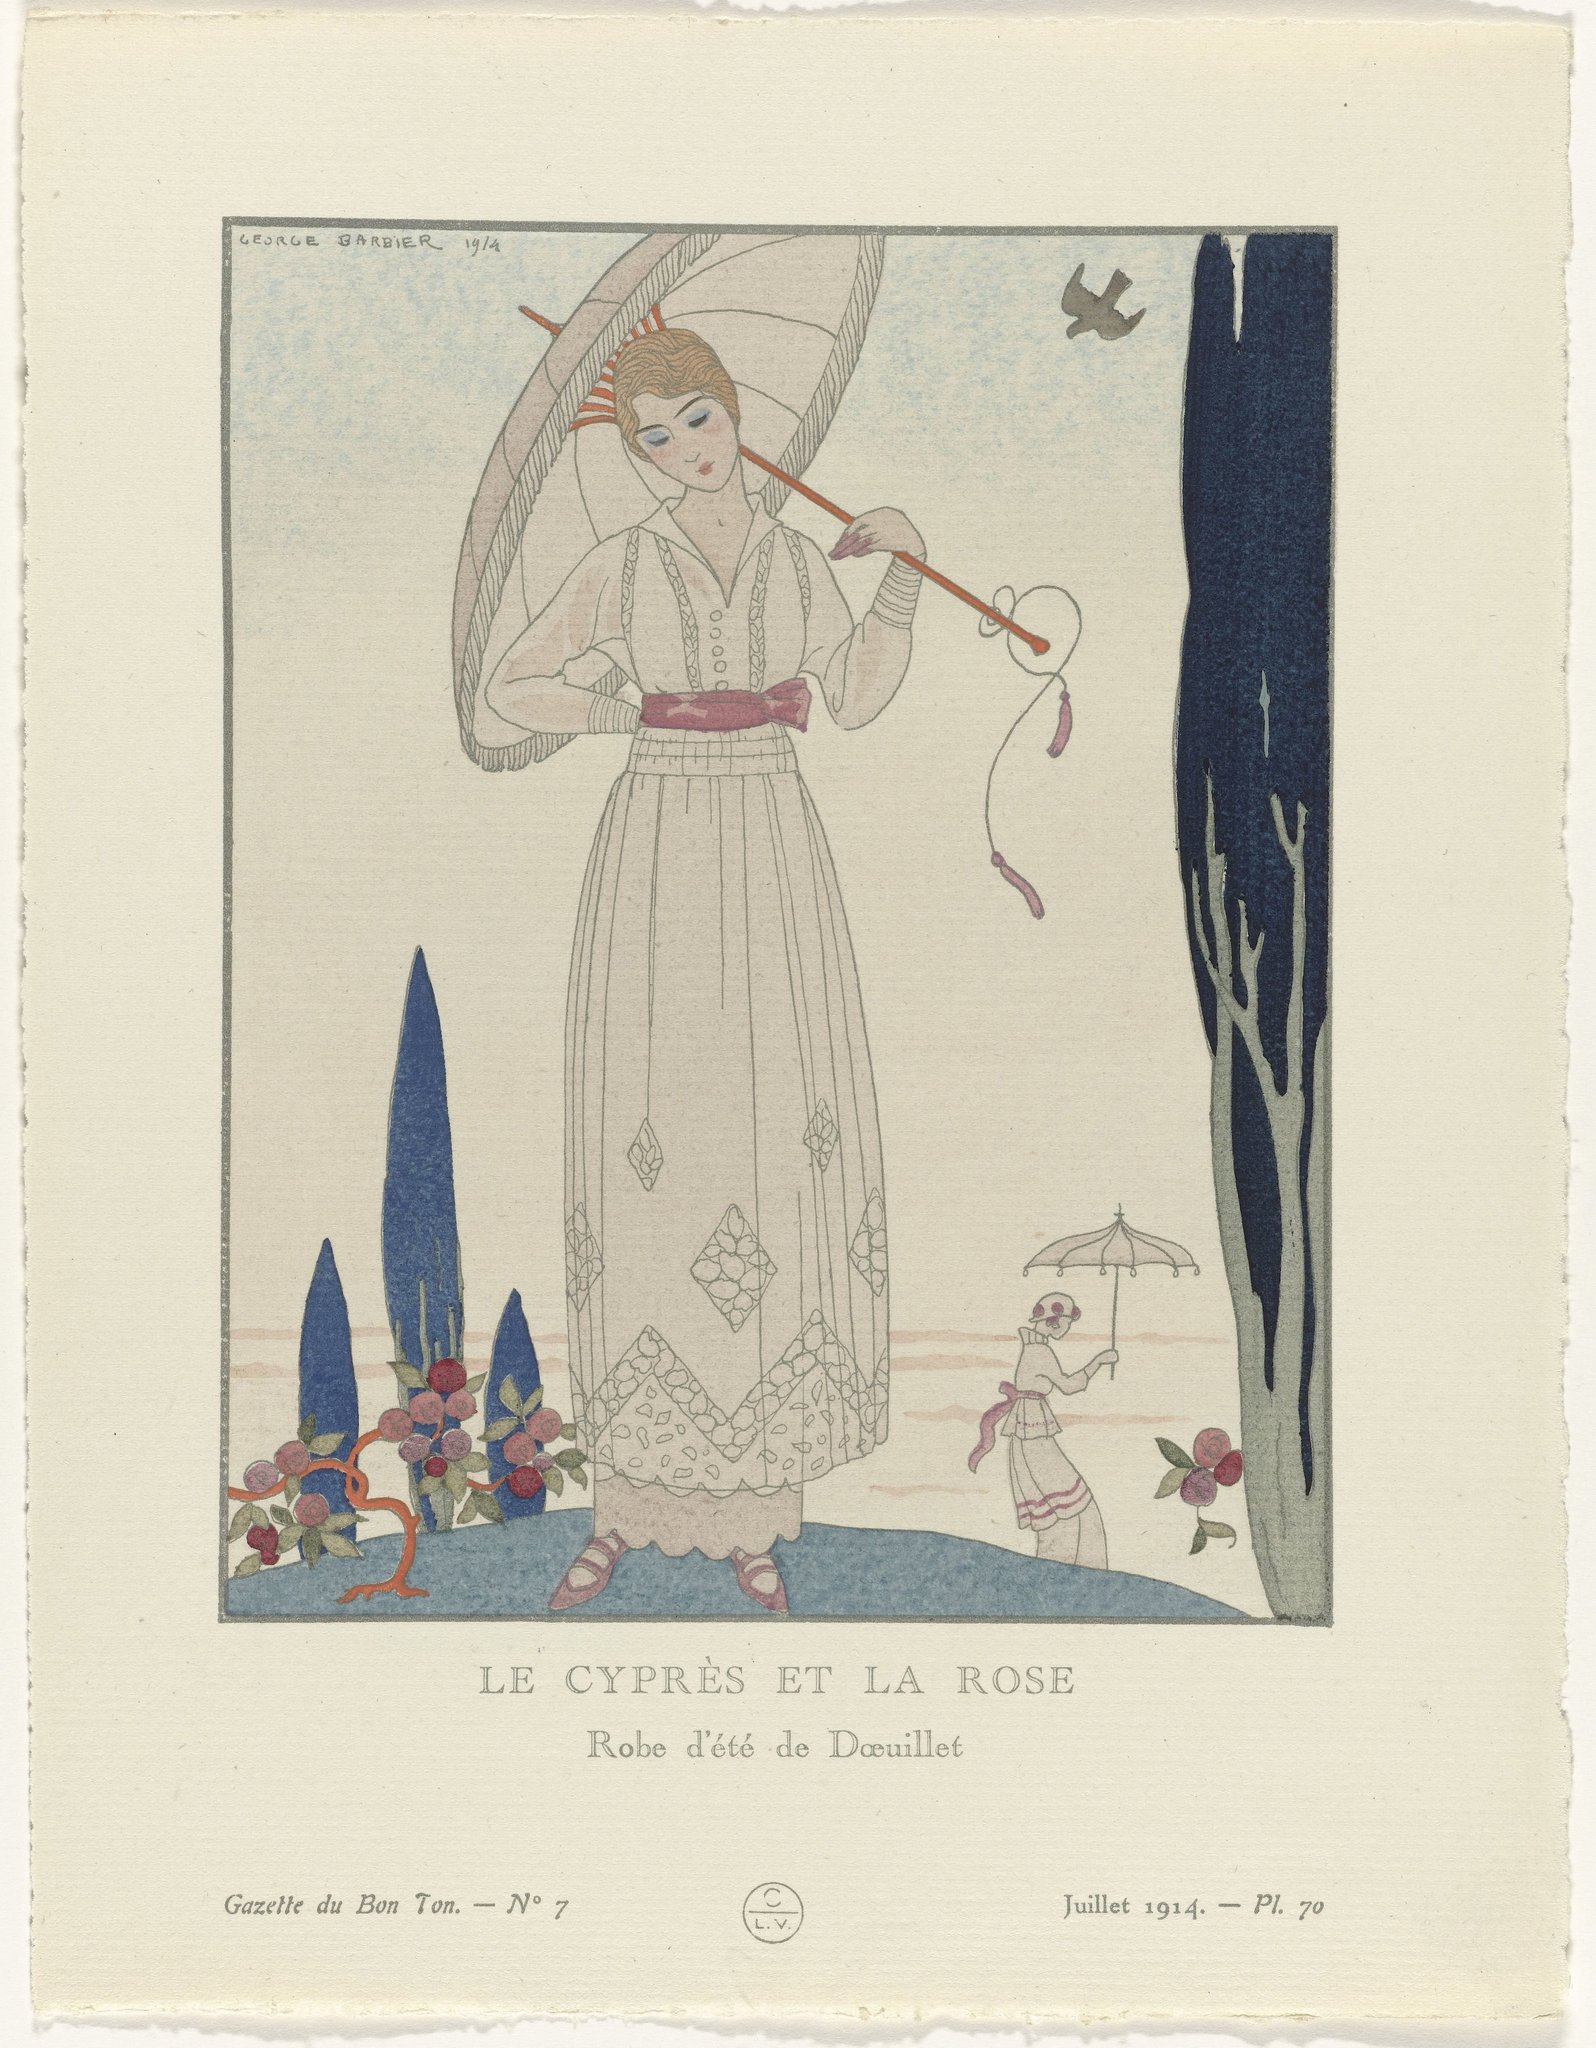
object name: fashion print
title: Gazette du Bon Ton, 1914 - No. 7, Pl. 70: Le cyprès et la rose / Robe d'été de Doeuillet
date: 1914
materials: paper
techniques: hand coloring, letterpress printing, lithograph, pochoir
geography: london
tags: embroidery (ornamentation) (+ women's clothes), fashion plates, dress, gown (+ women's clothes), flowers: rose, parasol, sunshade (+ women's clothes), belt, girdle, waistband (+ women's clothes)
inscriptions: date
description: Vrouw met parasol, gekleed in een zomerjapon van Doeuillet, staand in een landschap met cipressen en rozen. Planche 70 uit Gazette du Bon Ton 1914, No. 7. Uitleg over de kleding op pagina "Explication des Planches".